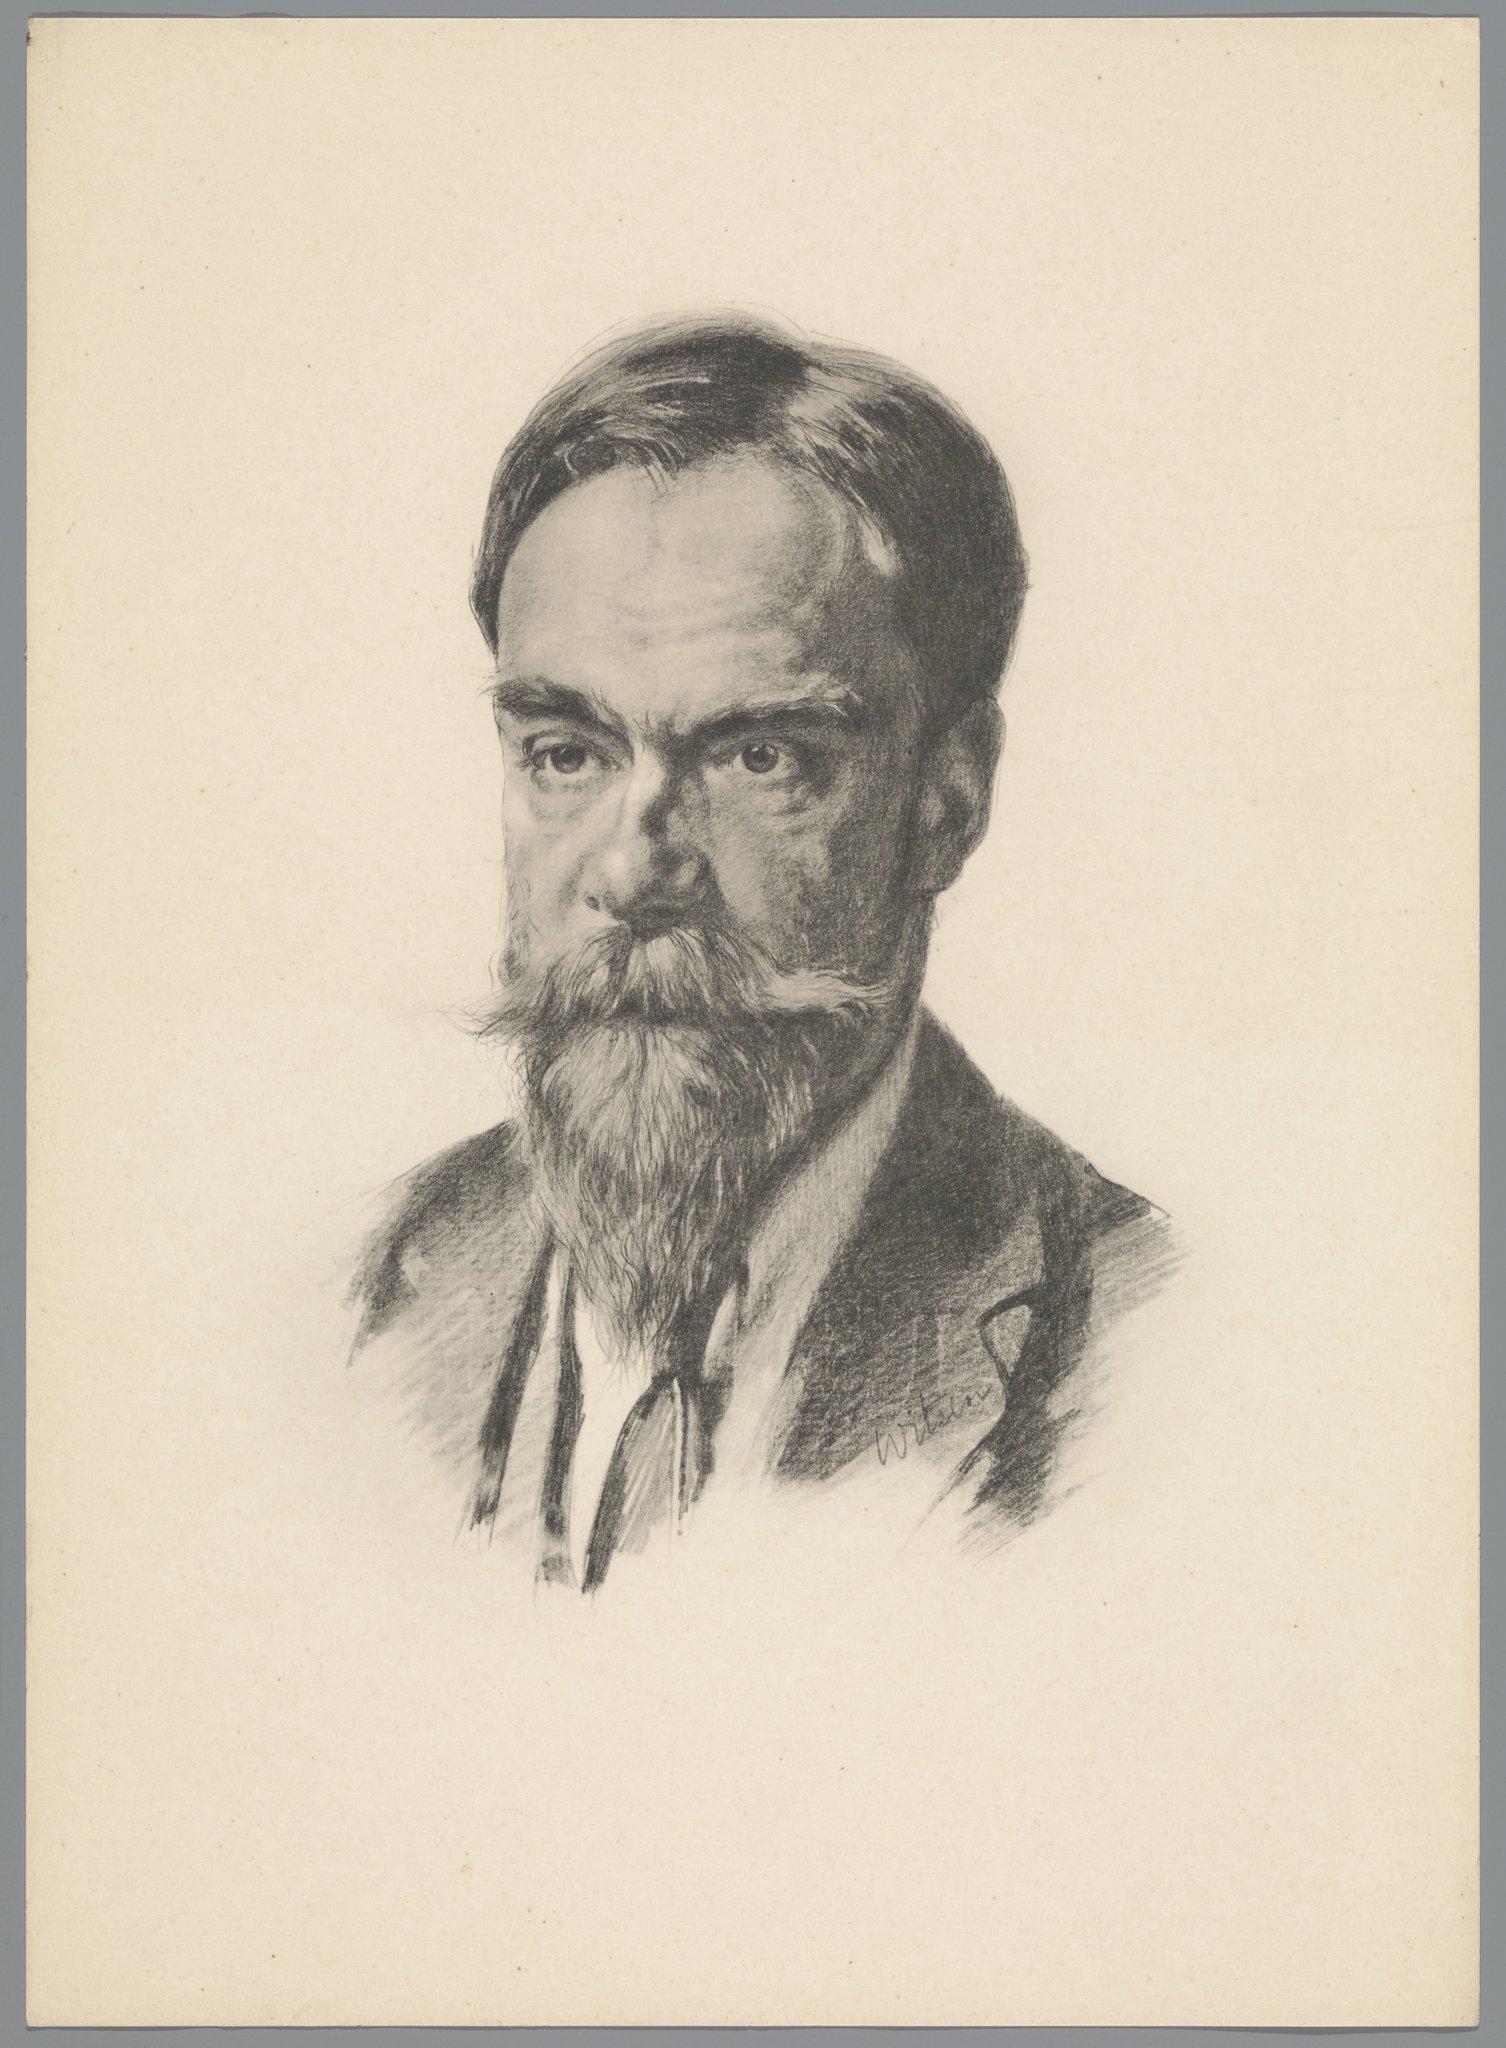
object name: print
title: Reproductie naar krijttekening met portret van Frans Coenen Jr.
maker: Anonymous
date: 1860-1915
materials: paper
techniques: photograph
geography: netherlands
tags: amsterdam, frans coenen (1866-1936)